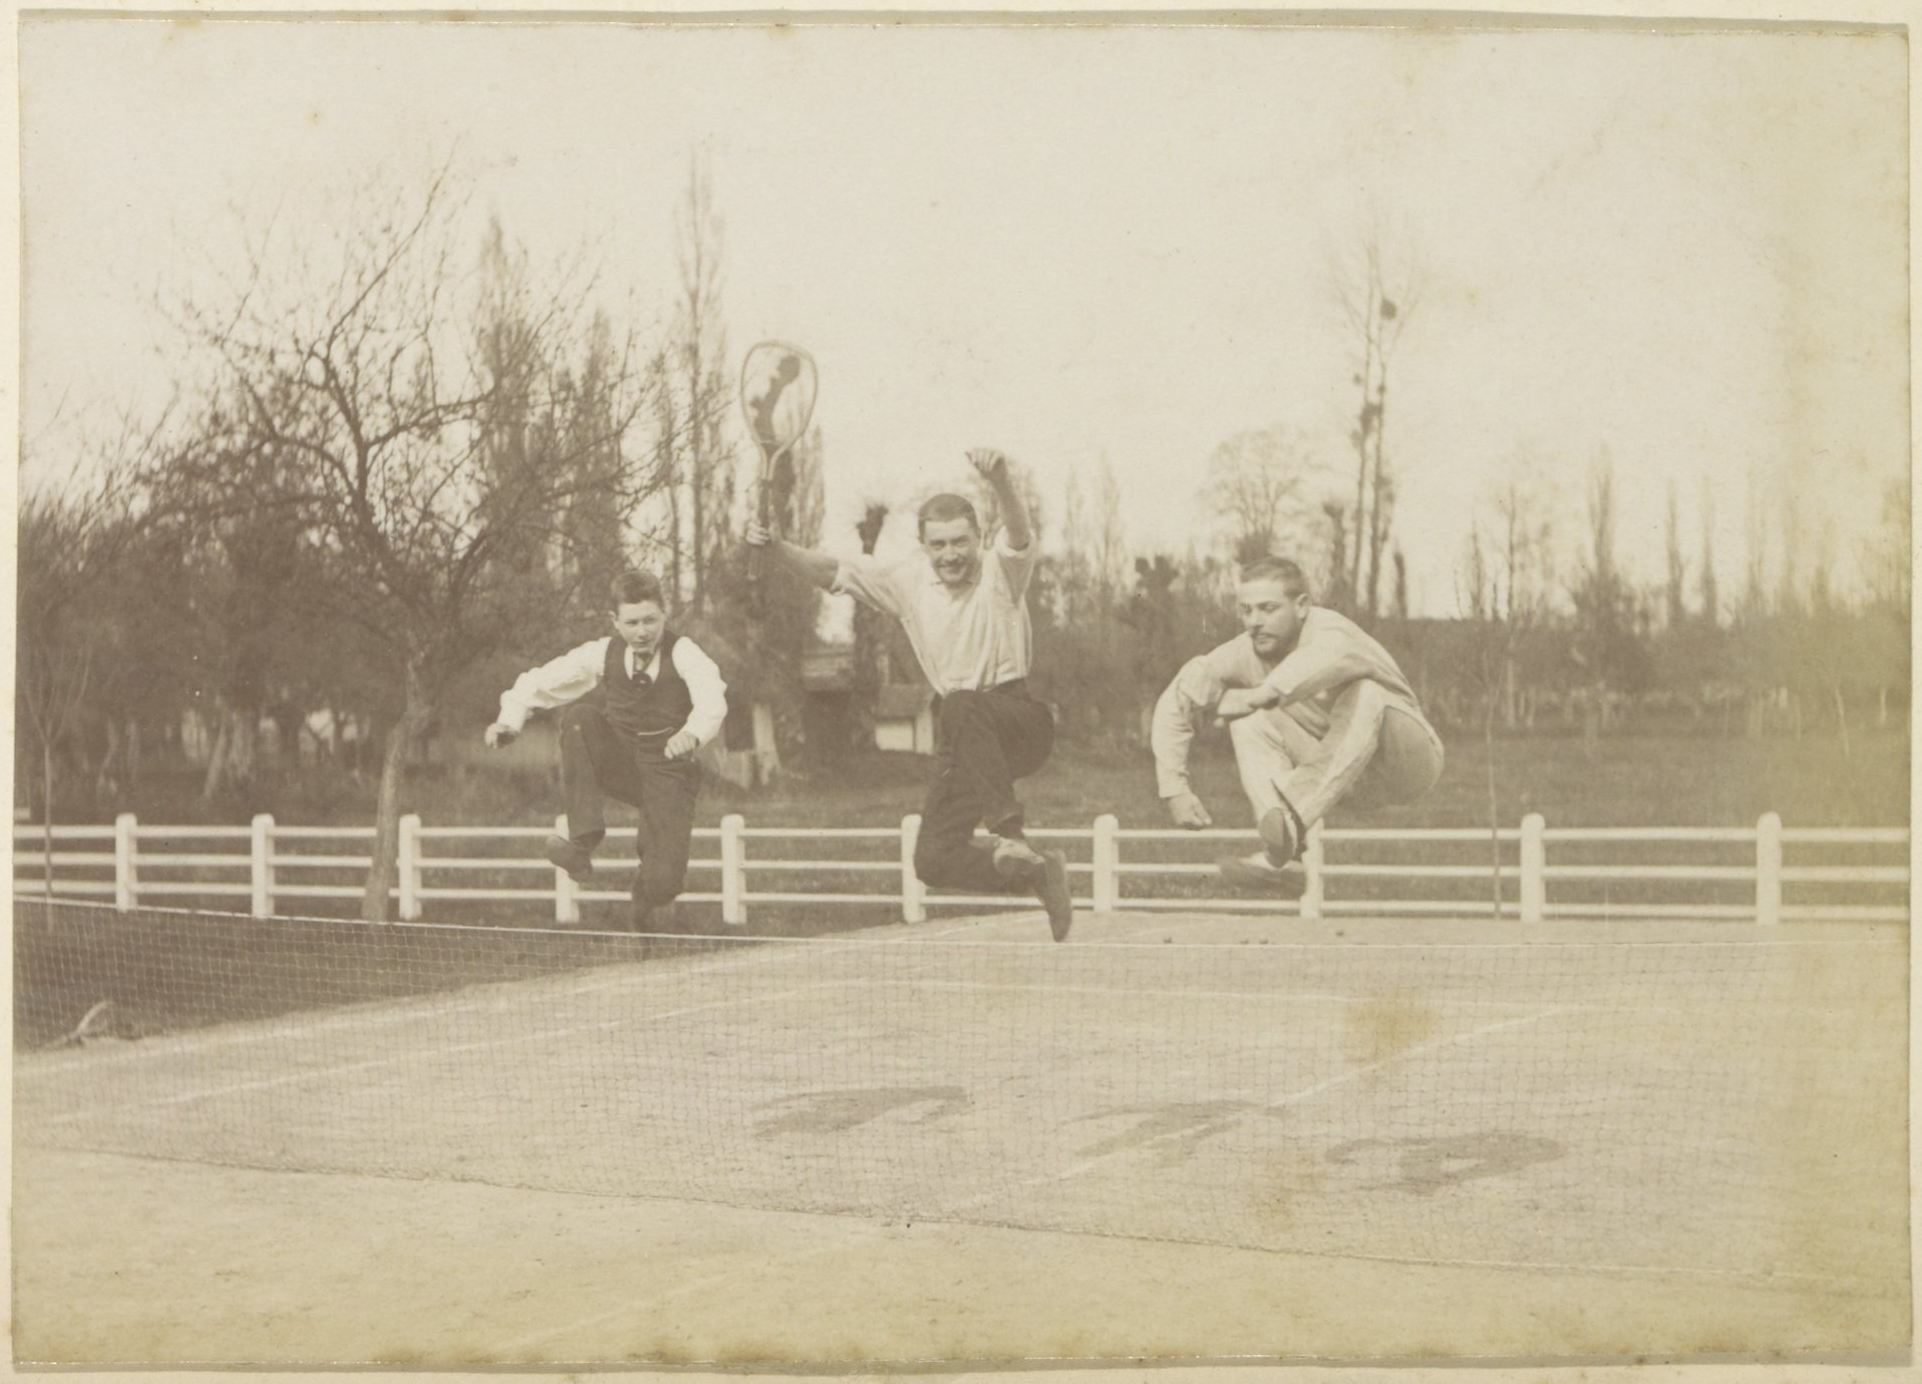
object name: photograph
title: Drie Franse mannen springen over een tennisnet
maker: Anonymous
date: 1900-1910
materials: paper, photographic support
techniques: albumen print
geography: france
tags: jumping games, tennis, lawn-tennis, adult man, france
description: Onderdeel van Fotoalbum van een Franse amateurfotograaf met opnames van een familie, distilleerderij Delizy & Doistau Fils, het leger en bezienswaardigheden in Frankrijk.